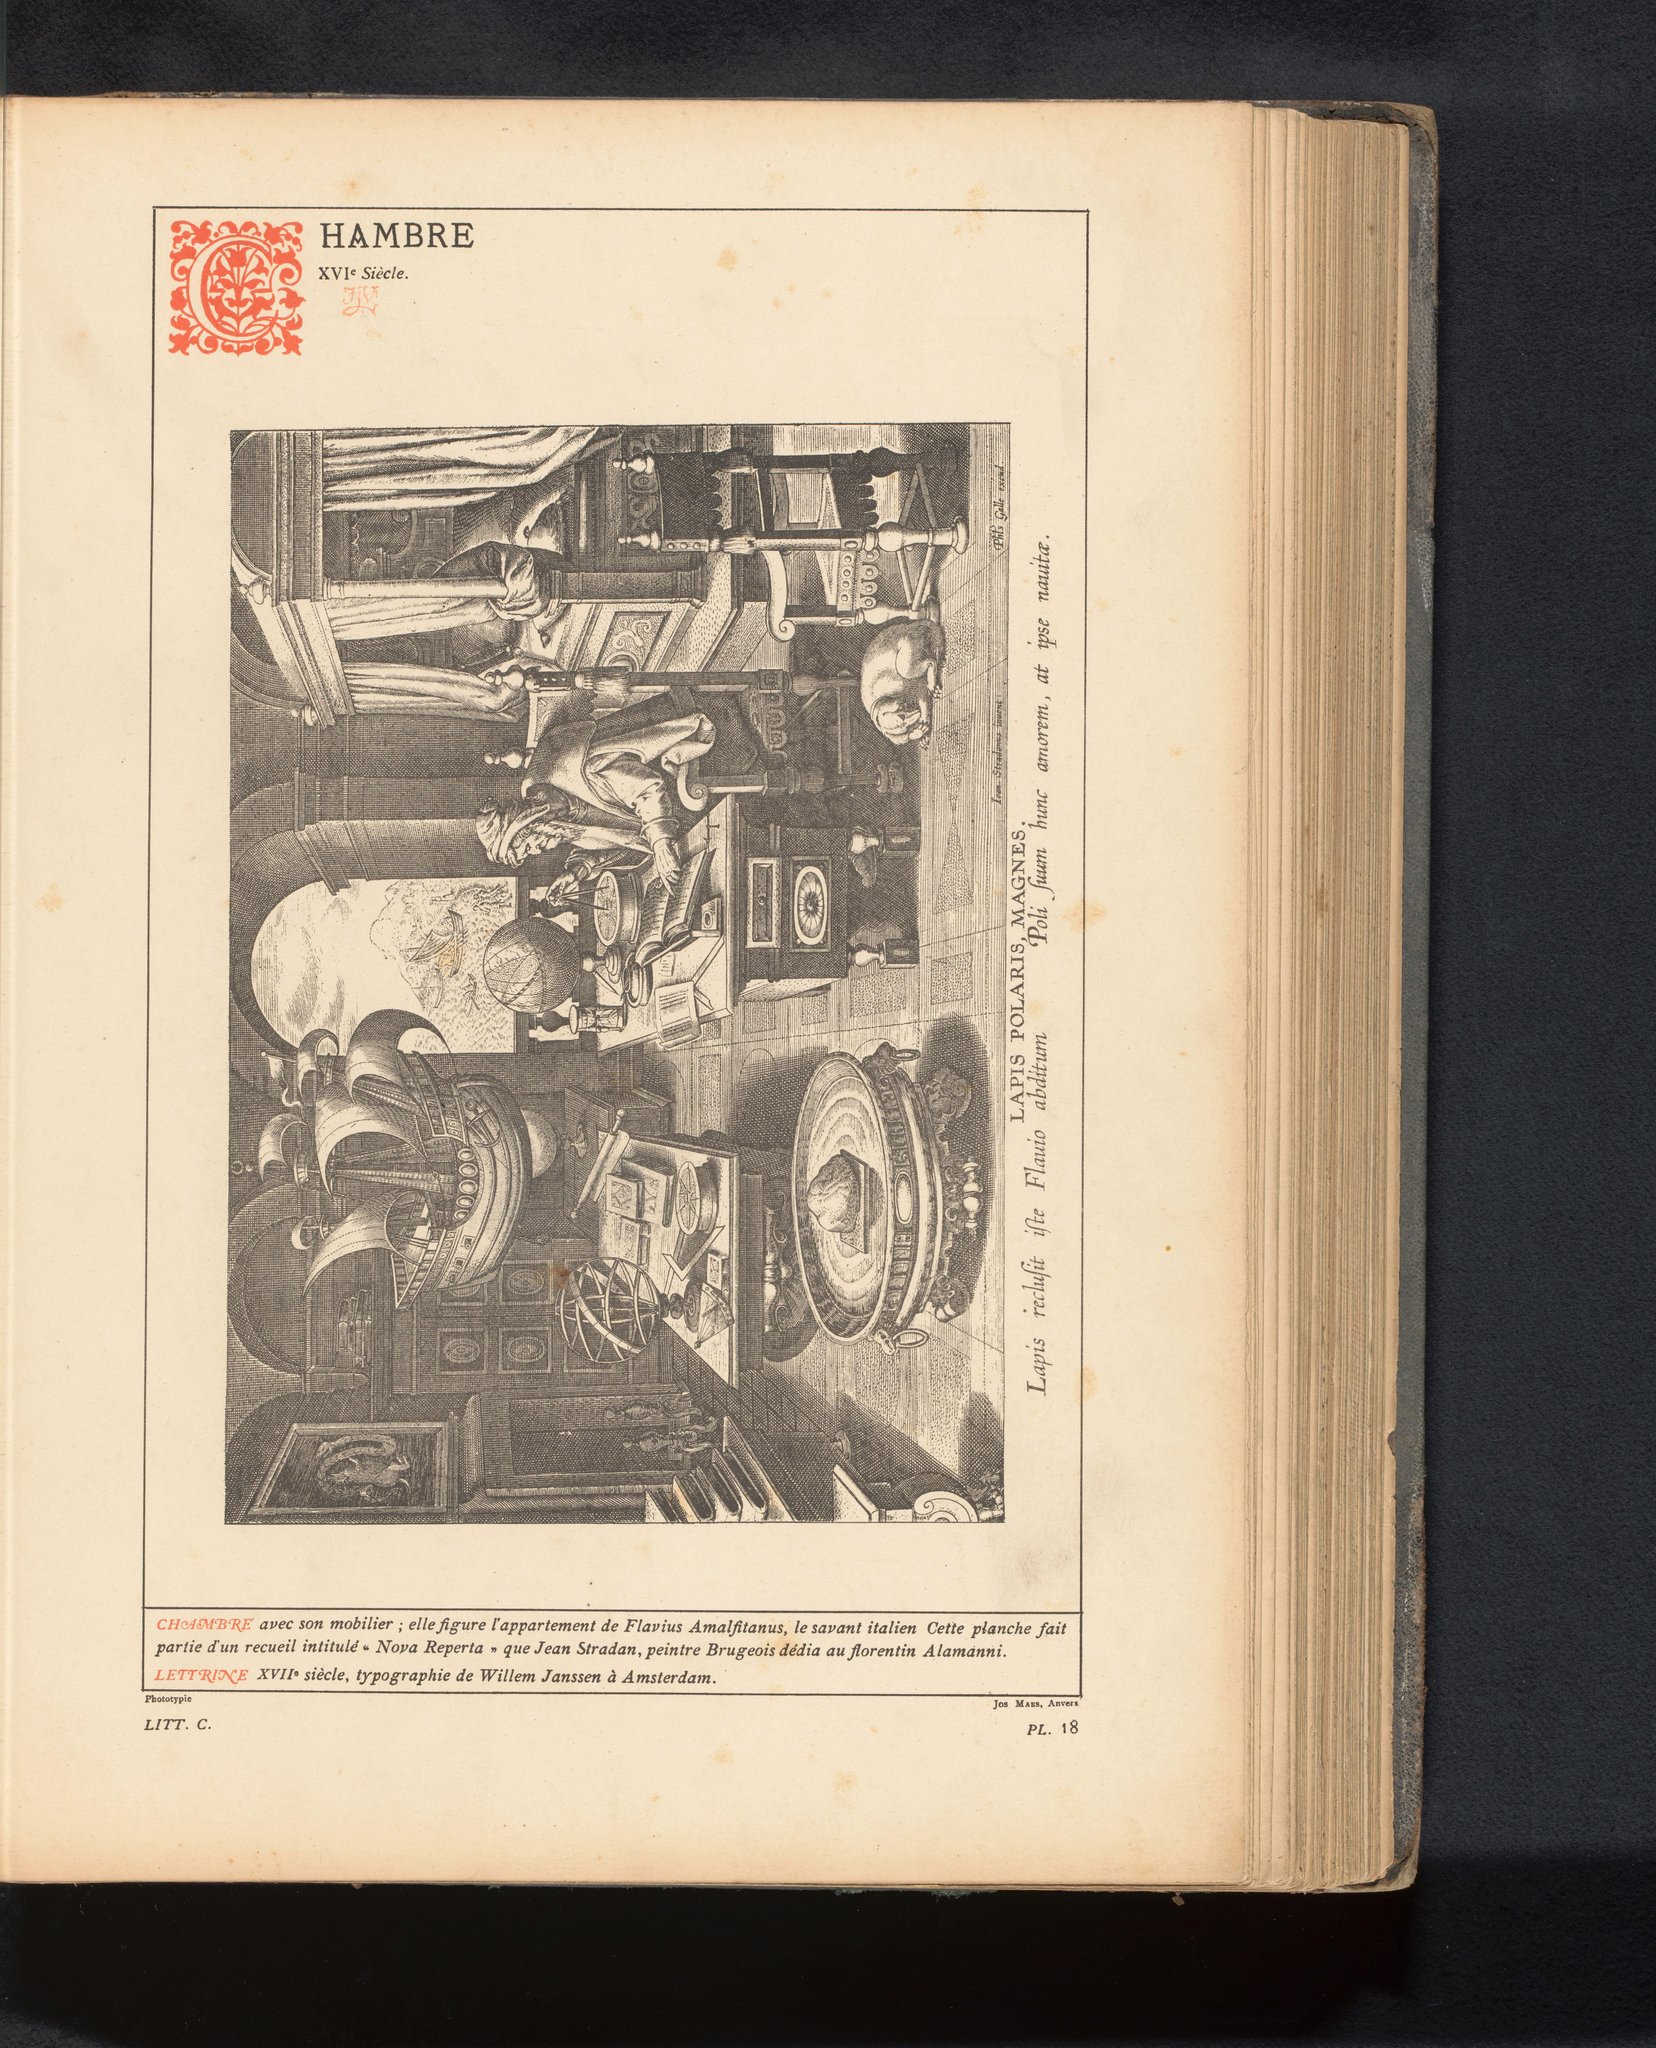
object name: photomechanical print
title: Reproductie van Lapis Polaris Magnes naar Jan van der Straet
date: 1875-1880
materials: paper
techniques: photolithography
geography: antwerp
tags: scholar in his study, study; 'studiolo'; library, position-finding at sea; nautical instruments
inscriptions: inscription: ‘Chambre avec son (...)’, inscription: ‘LITT: C. - PL. 18’, monogram: ‘JJvY’